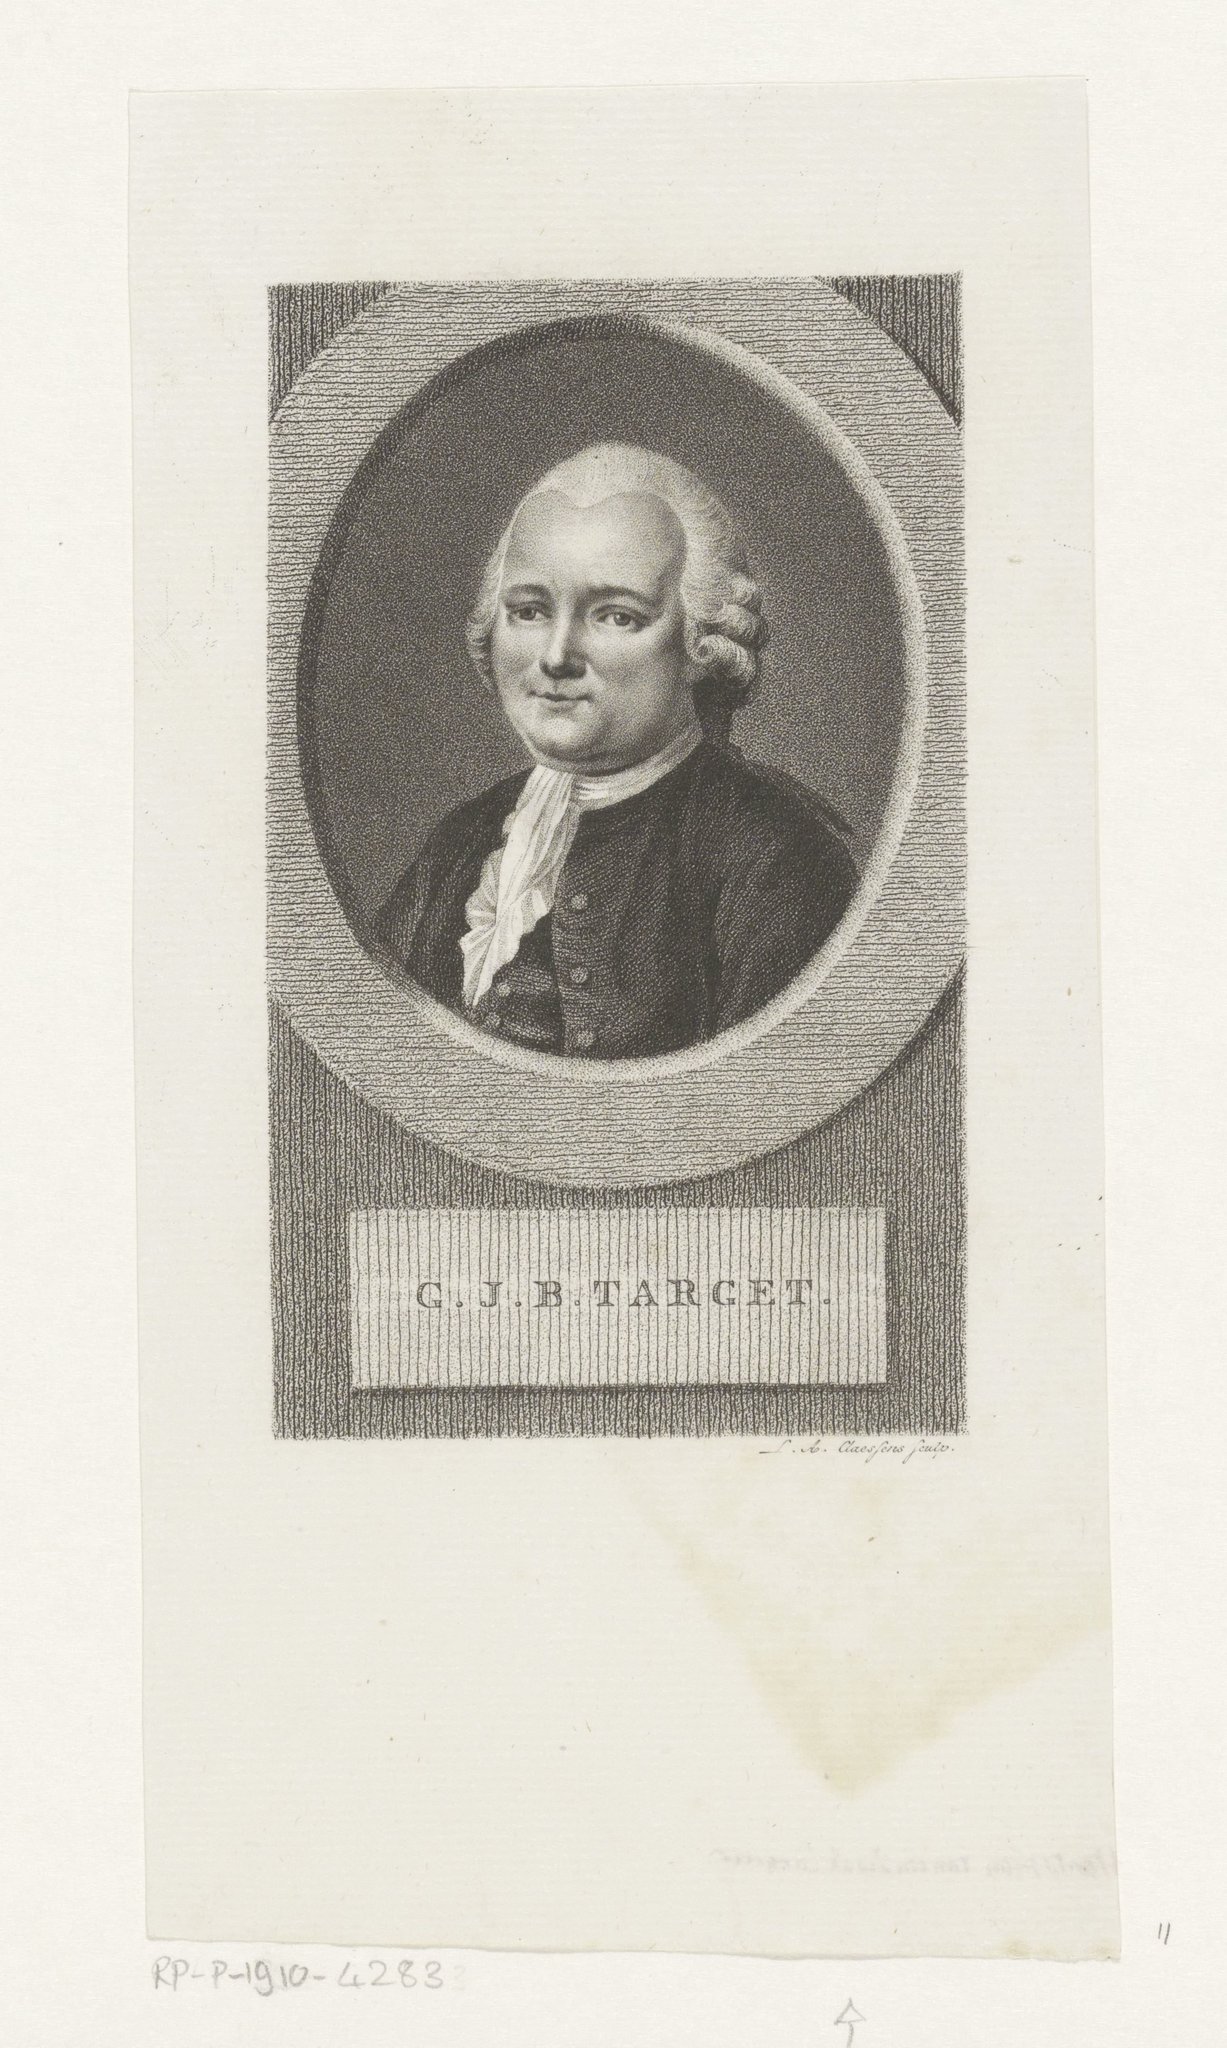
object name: print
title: Portret van Guy-Jean-Baptiste Target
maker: lambertus antonius claessens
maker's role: draughtsman, print maker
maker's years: 1763-1834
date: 1792-1808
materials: paper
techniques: engraving, etching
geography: amsterdam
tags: politician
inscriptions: inscription: ‘Fransman van een Zwak Caracter’, collector's mark: Lugt 2228